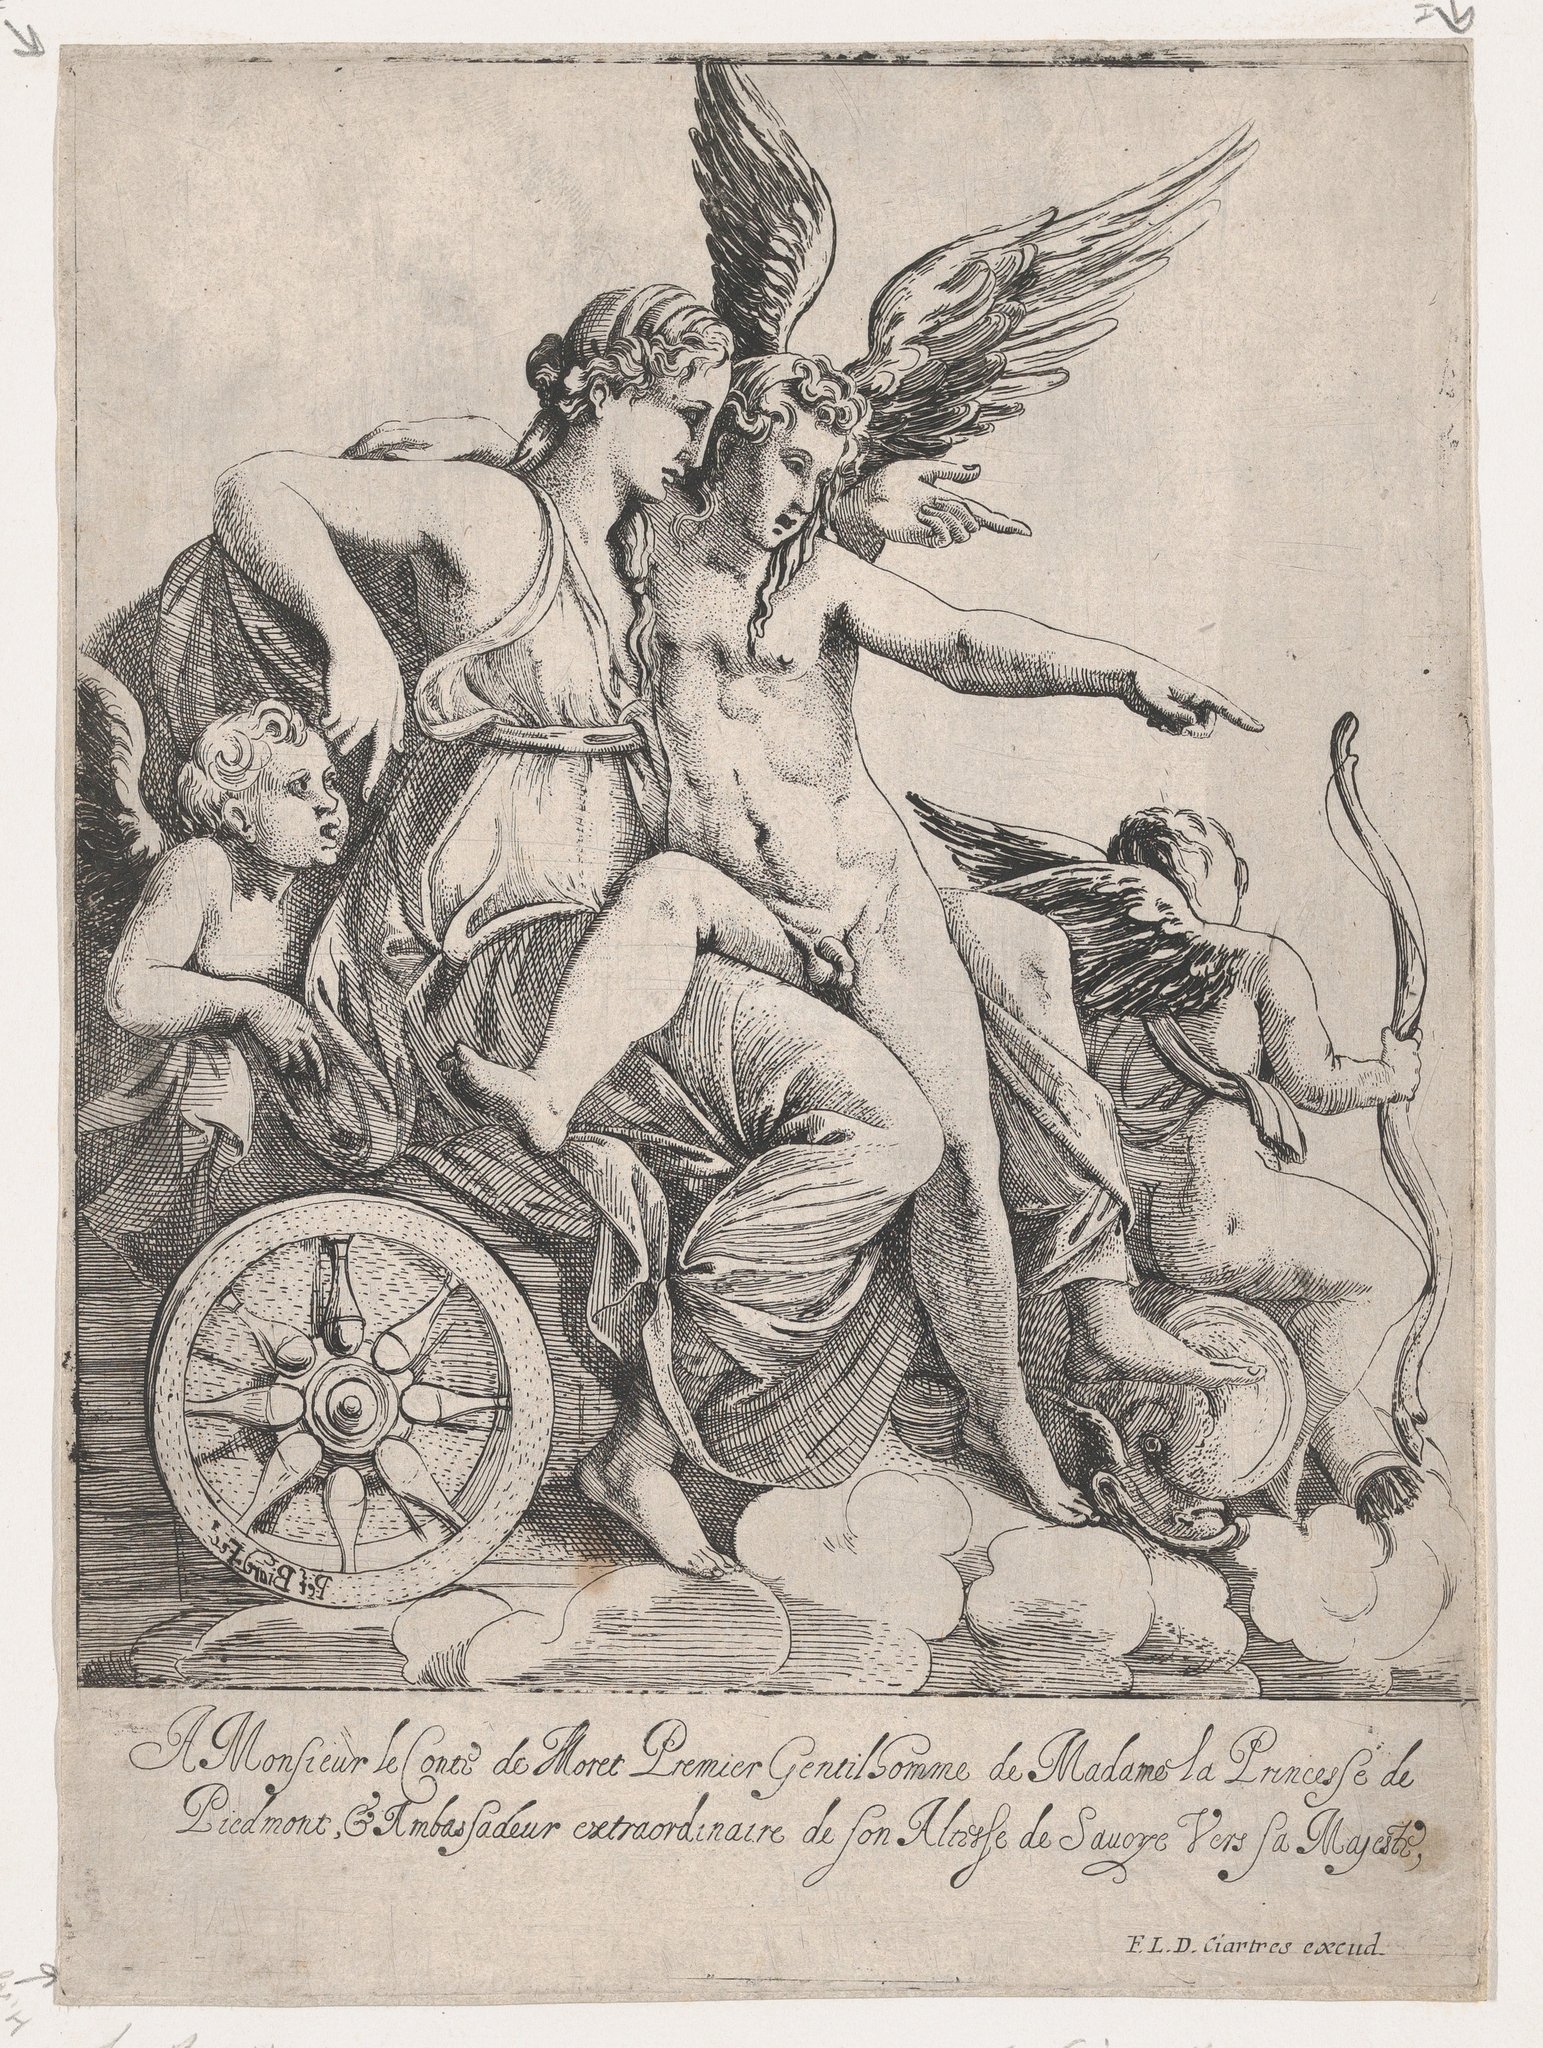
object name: print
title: Venus and Cupid on a Chariot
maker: pierre biard ii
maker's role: artist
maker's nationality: french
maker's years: 1592-1661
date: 1607-1661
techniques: engraving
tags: cupid,venus,chariots